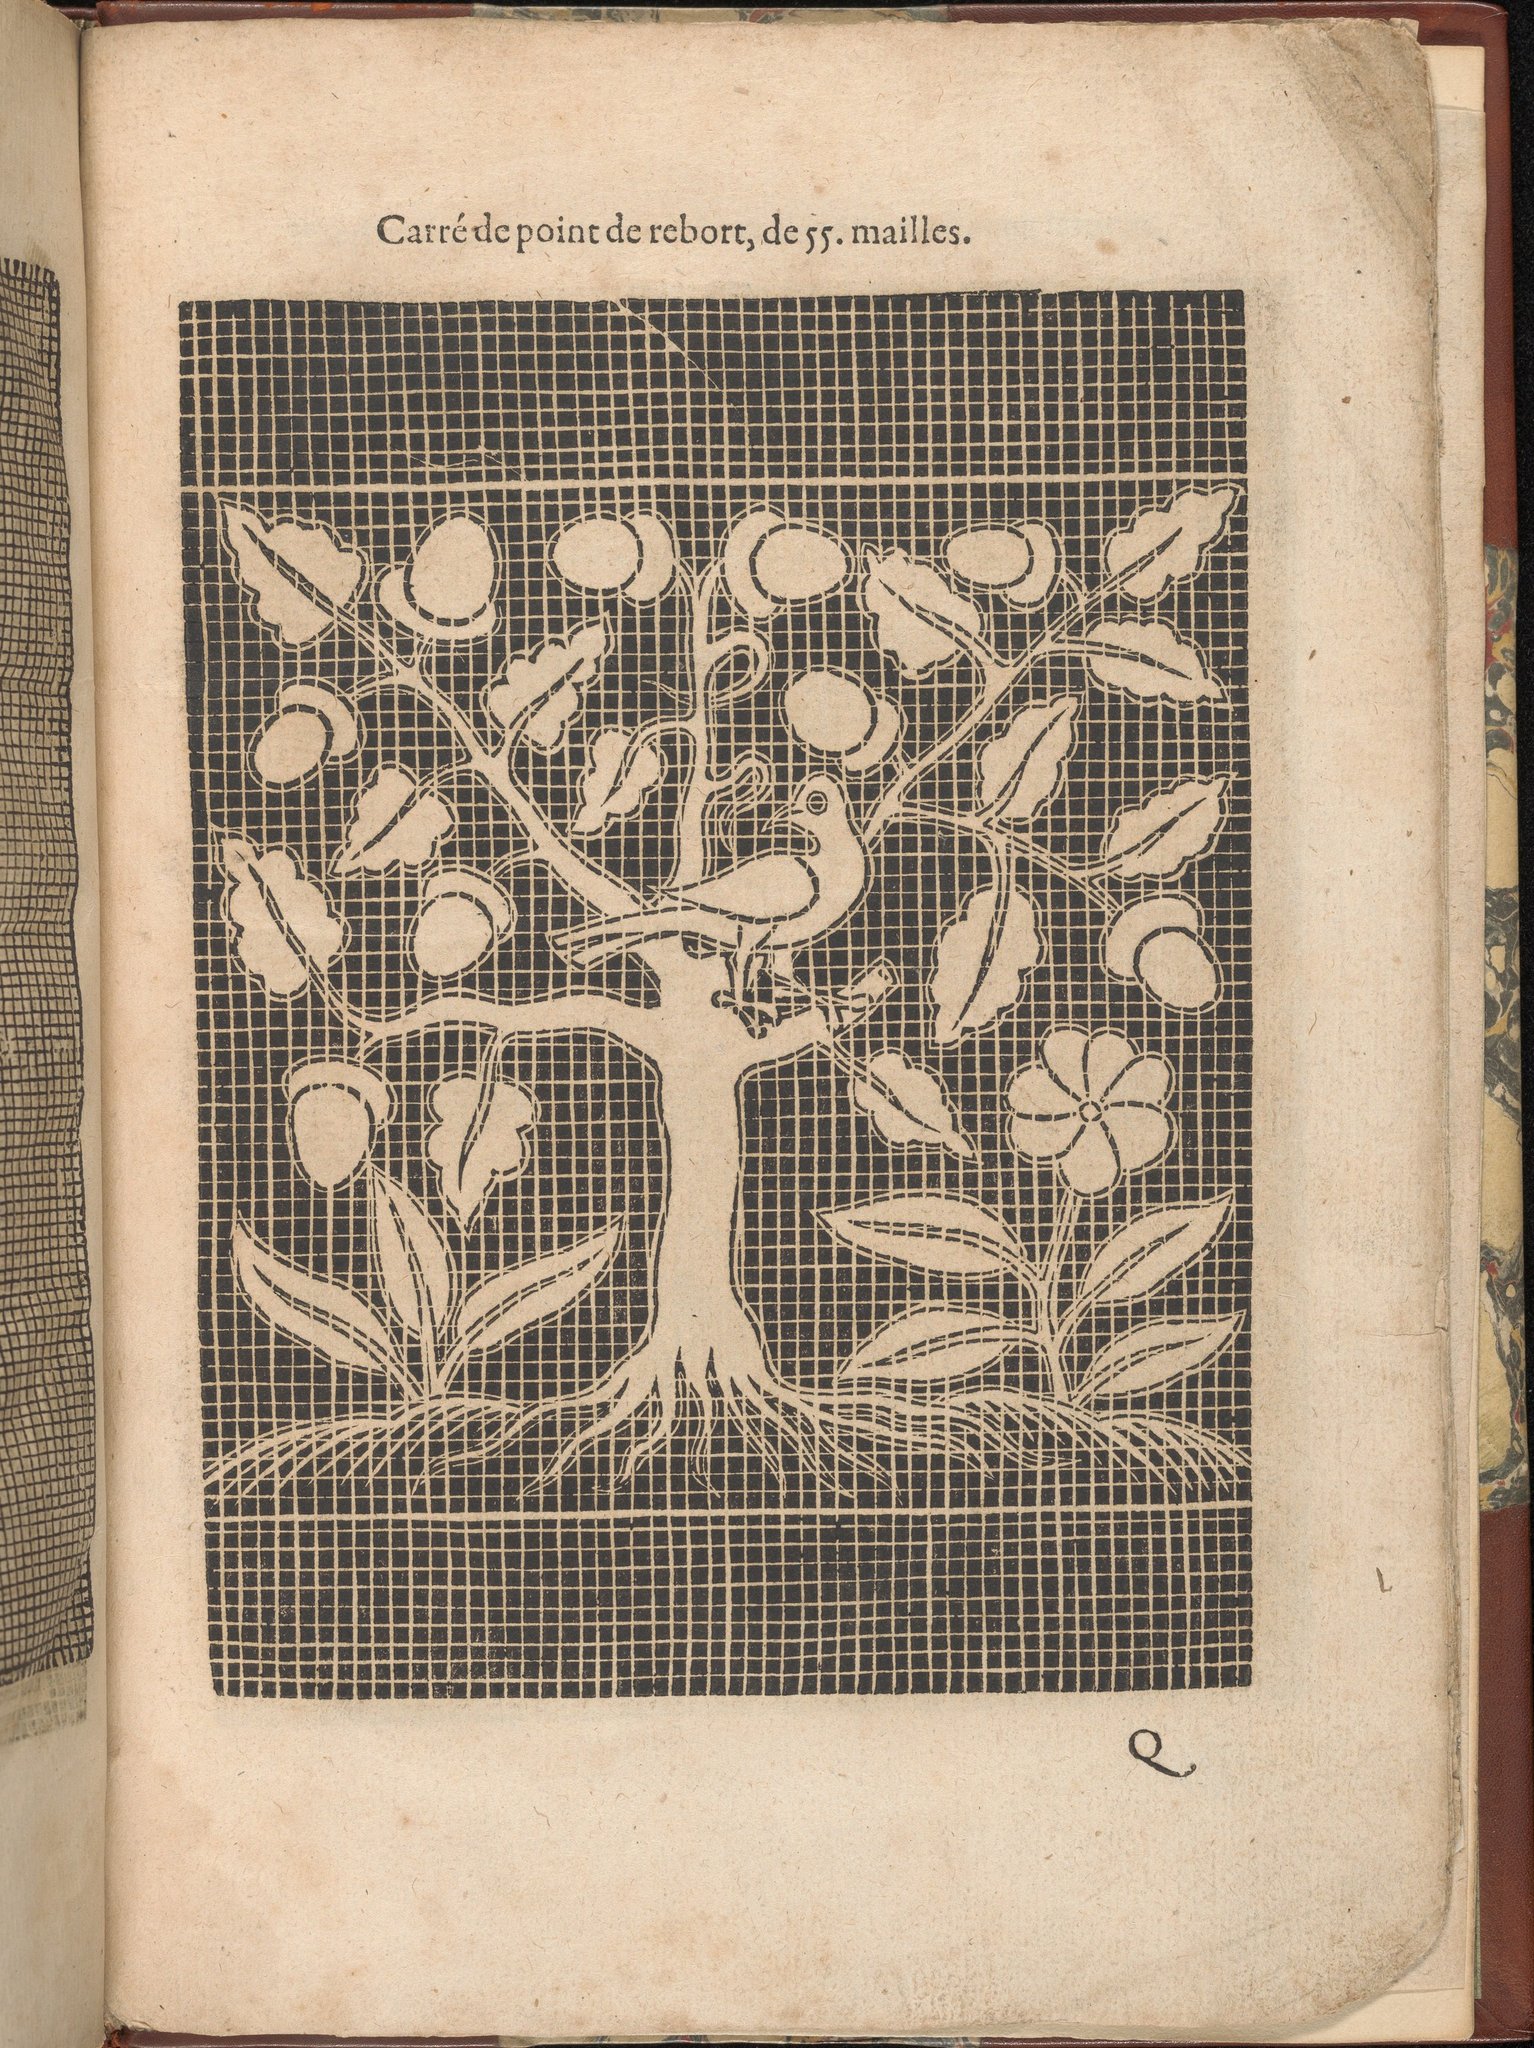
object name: book print ornament architecture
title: Les Secondes Oeuvres, et Subtiles Inventions De Lingerie du Seigneur Federic de Vinciolo Venitien, page 61 (recto)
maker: federico de vinciolo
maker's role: designer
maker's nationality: italian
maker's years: 1582-1599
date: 1603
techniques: woodcut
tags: birds,acorns